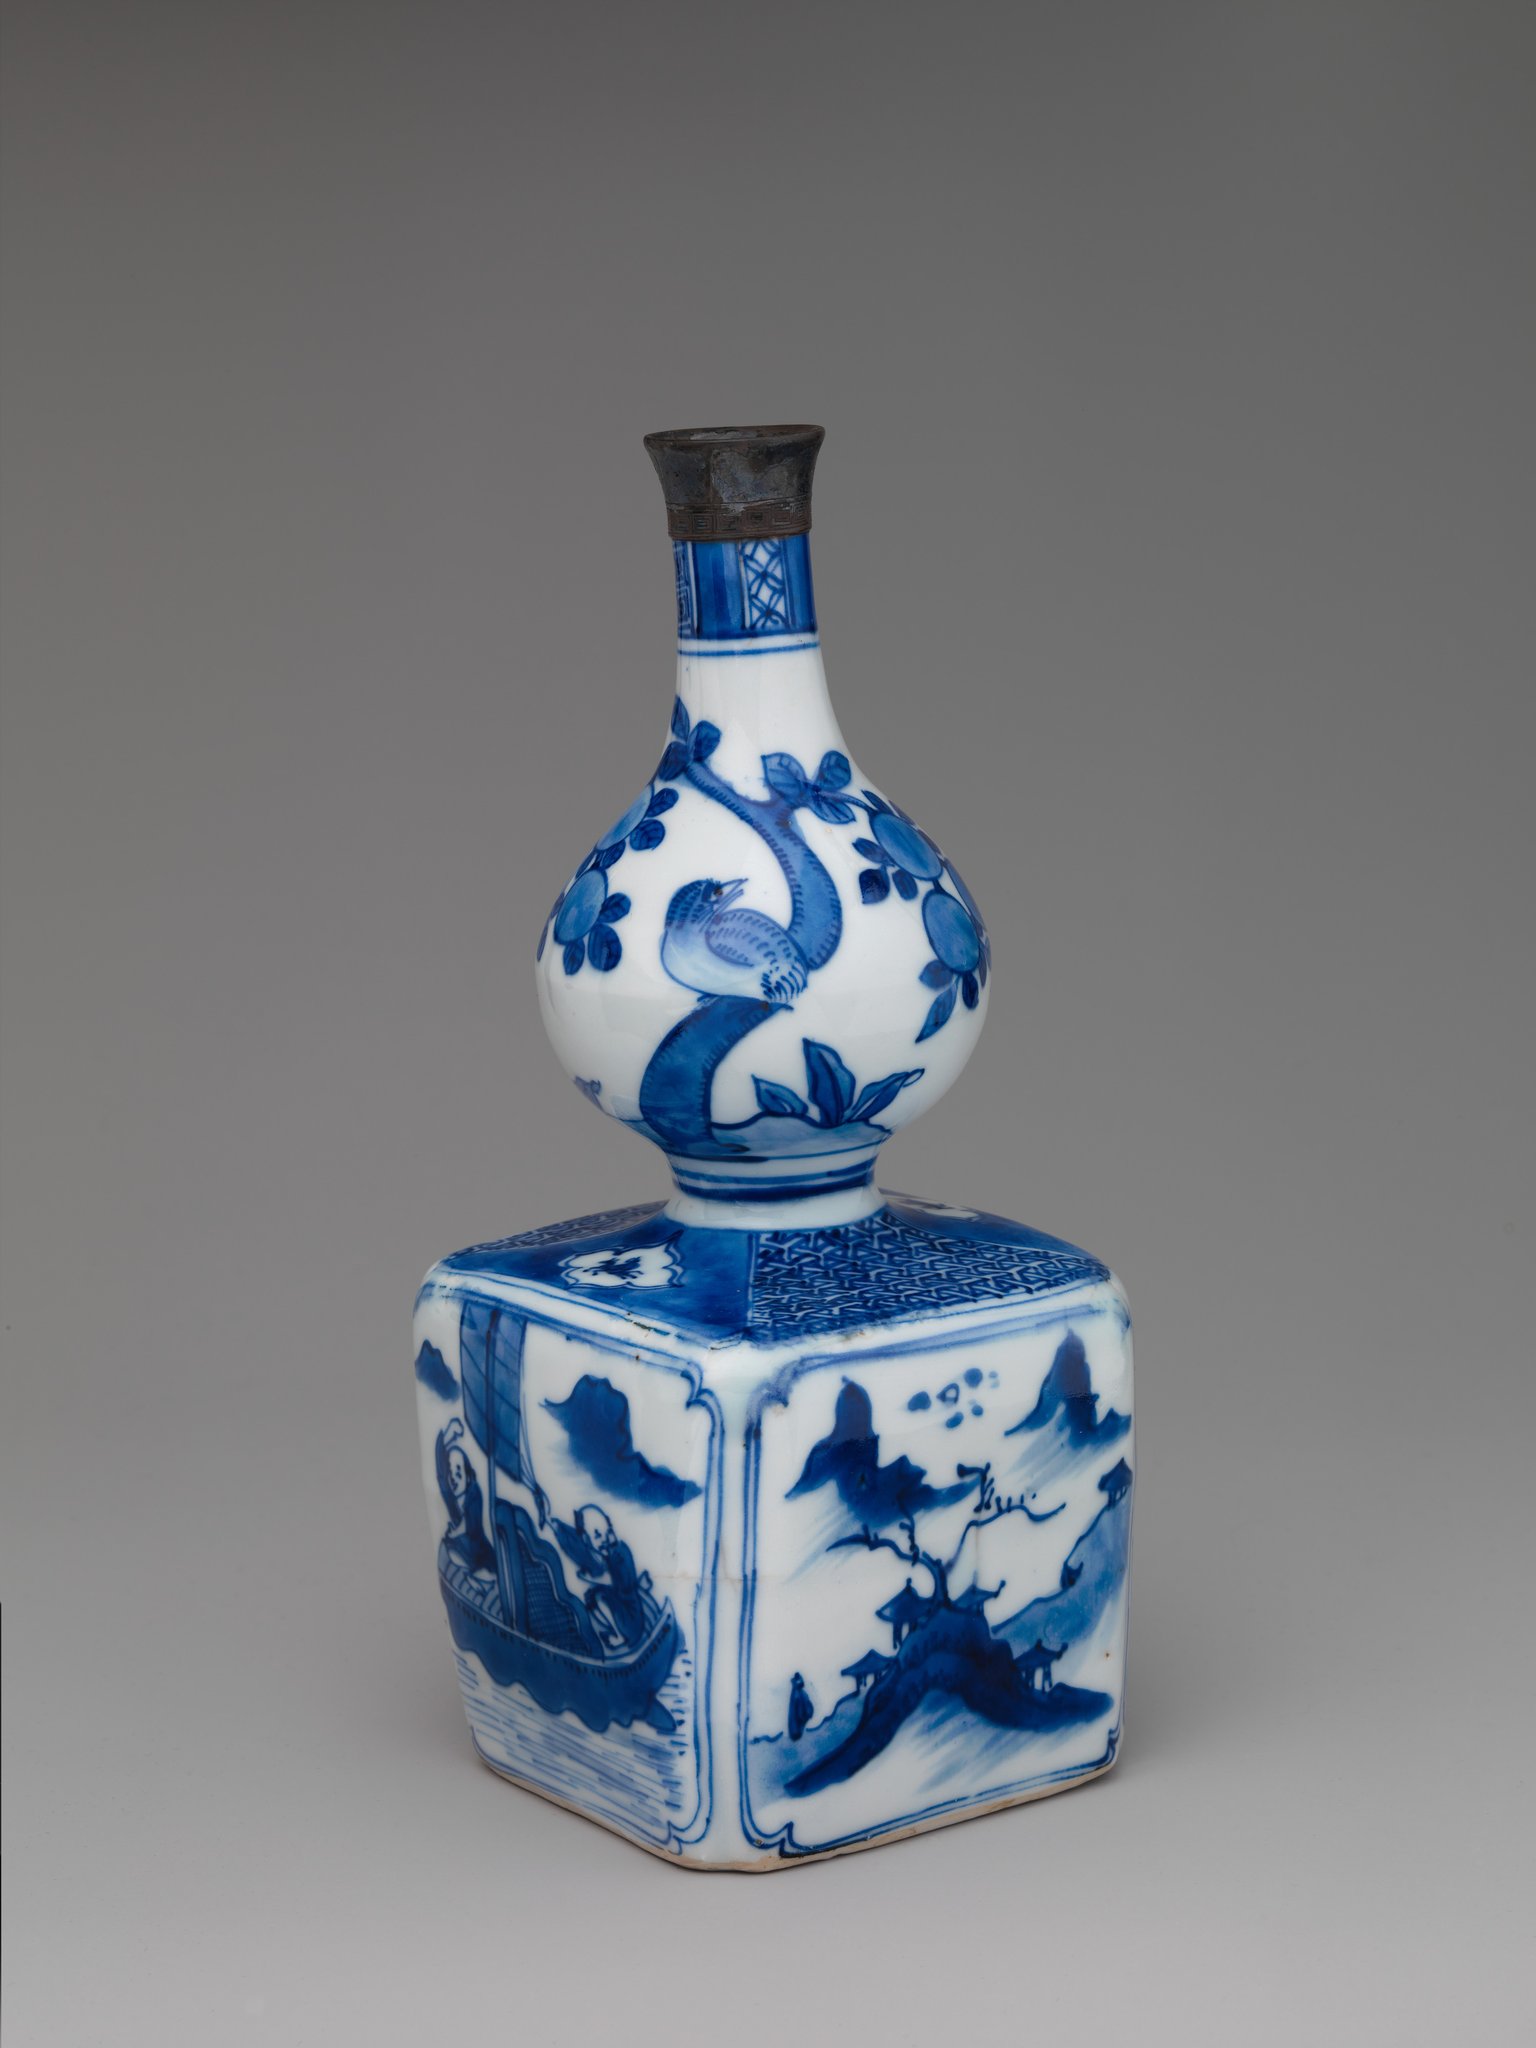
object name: bottle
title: Wine bottle with decoration of landscape and poem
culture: chinese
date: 1634-1666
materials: cobalt, porcelain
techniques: painting, underglaze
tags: birds,landscapes